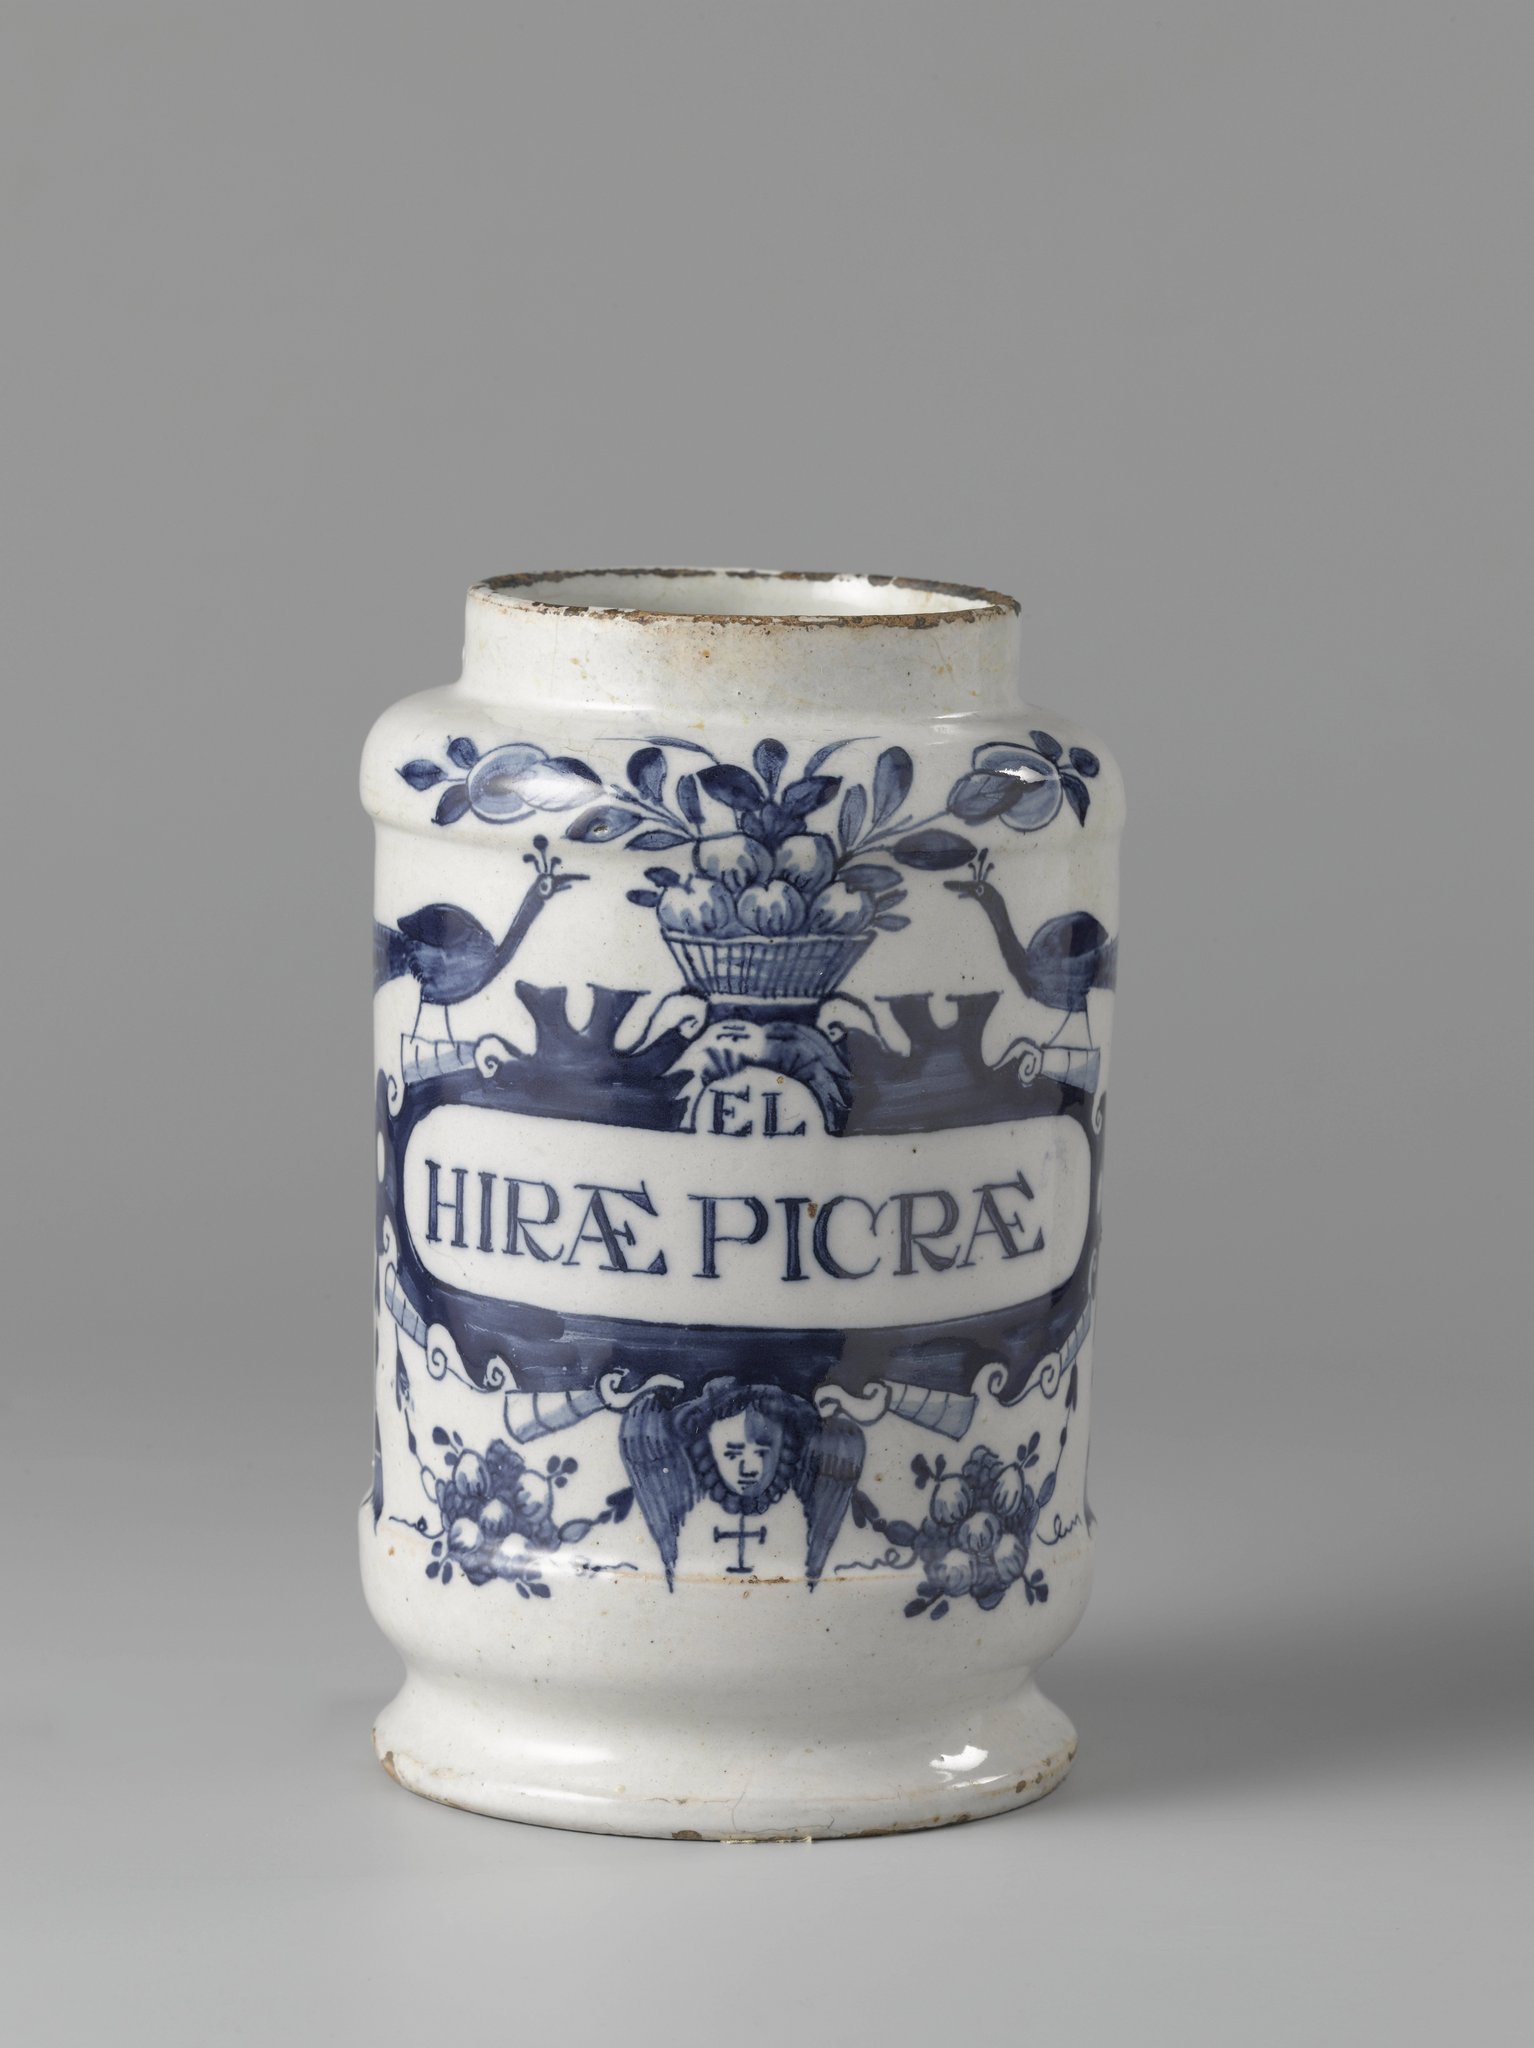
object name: pot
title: Apothekerspot 'EL HIRAE PICRAE'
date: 1770-1820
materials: earthenware, glaze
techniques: painted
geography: delft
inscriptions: mark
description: Apothekerspot van blauw beschilderde faience met opschrift: EL/ HIRAE PICRAE. De cilindrische pot heeft een ingesnoerde hals en voet en is gemerkt.